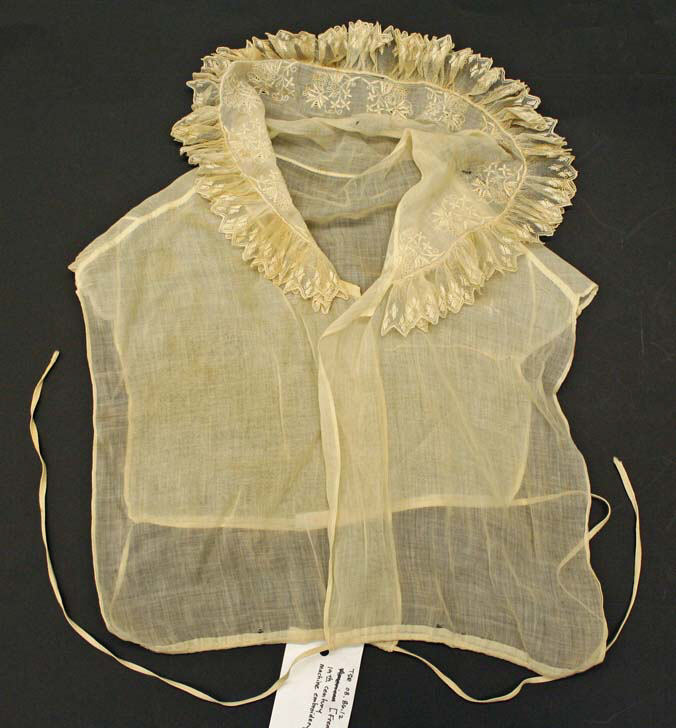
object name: chemise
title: Chemisette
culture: french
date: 1701-1900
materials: cotton